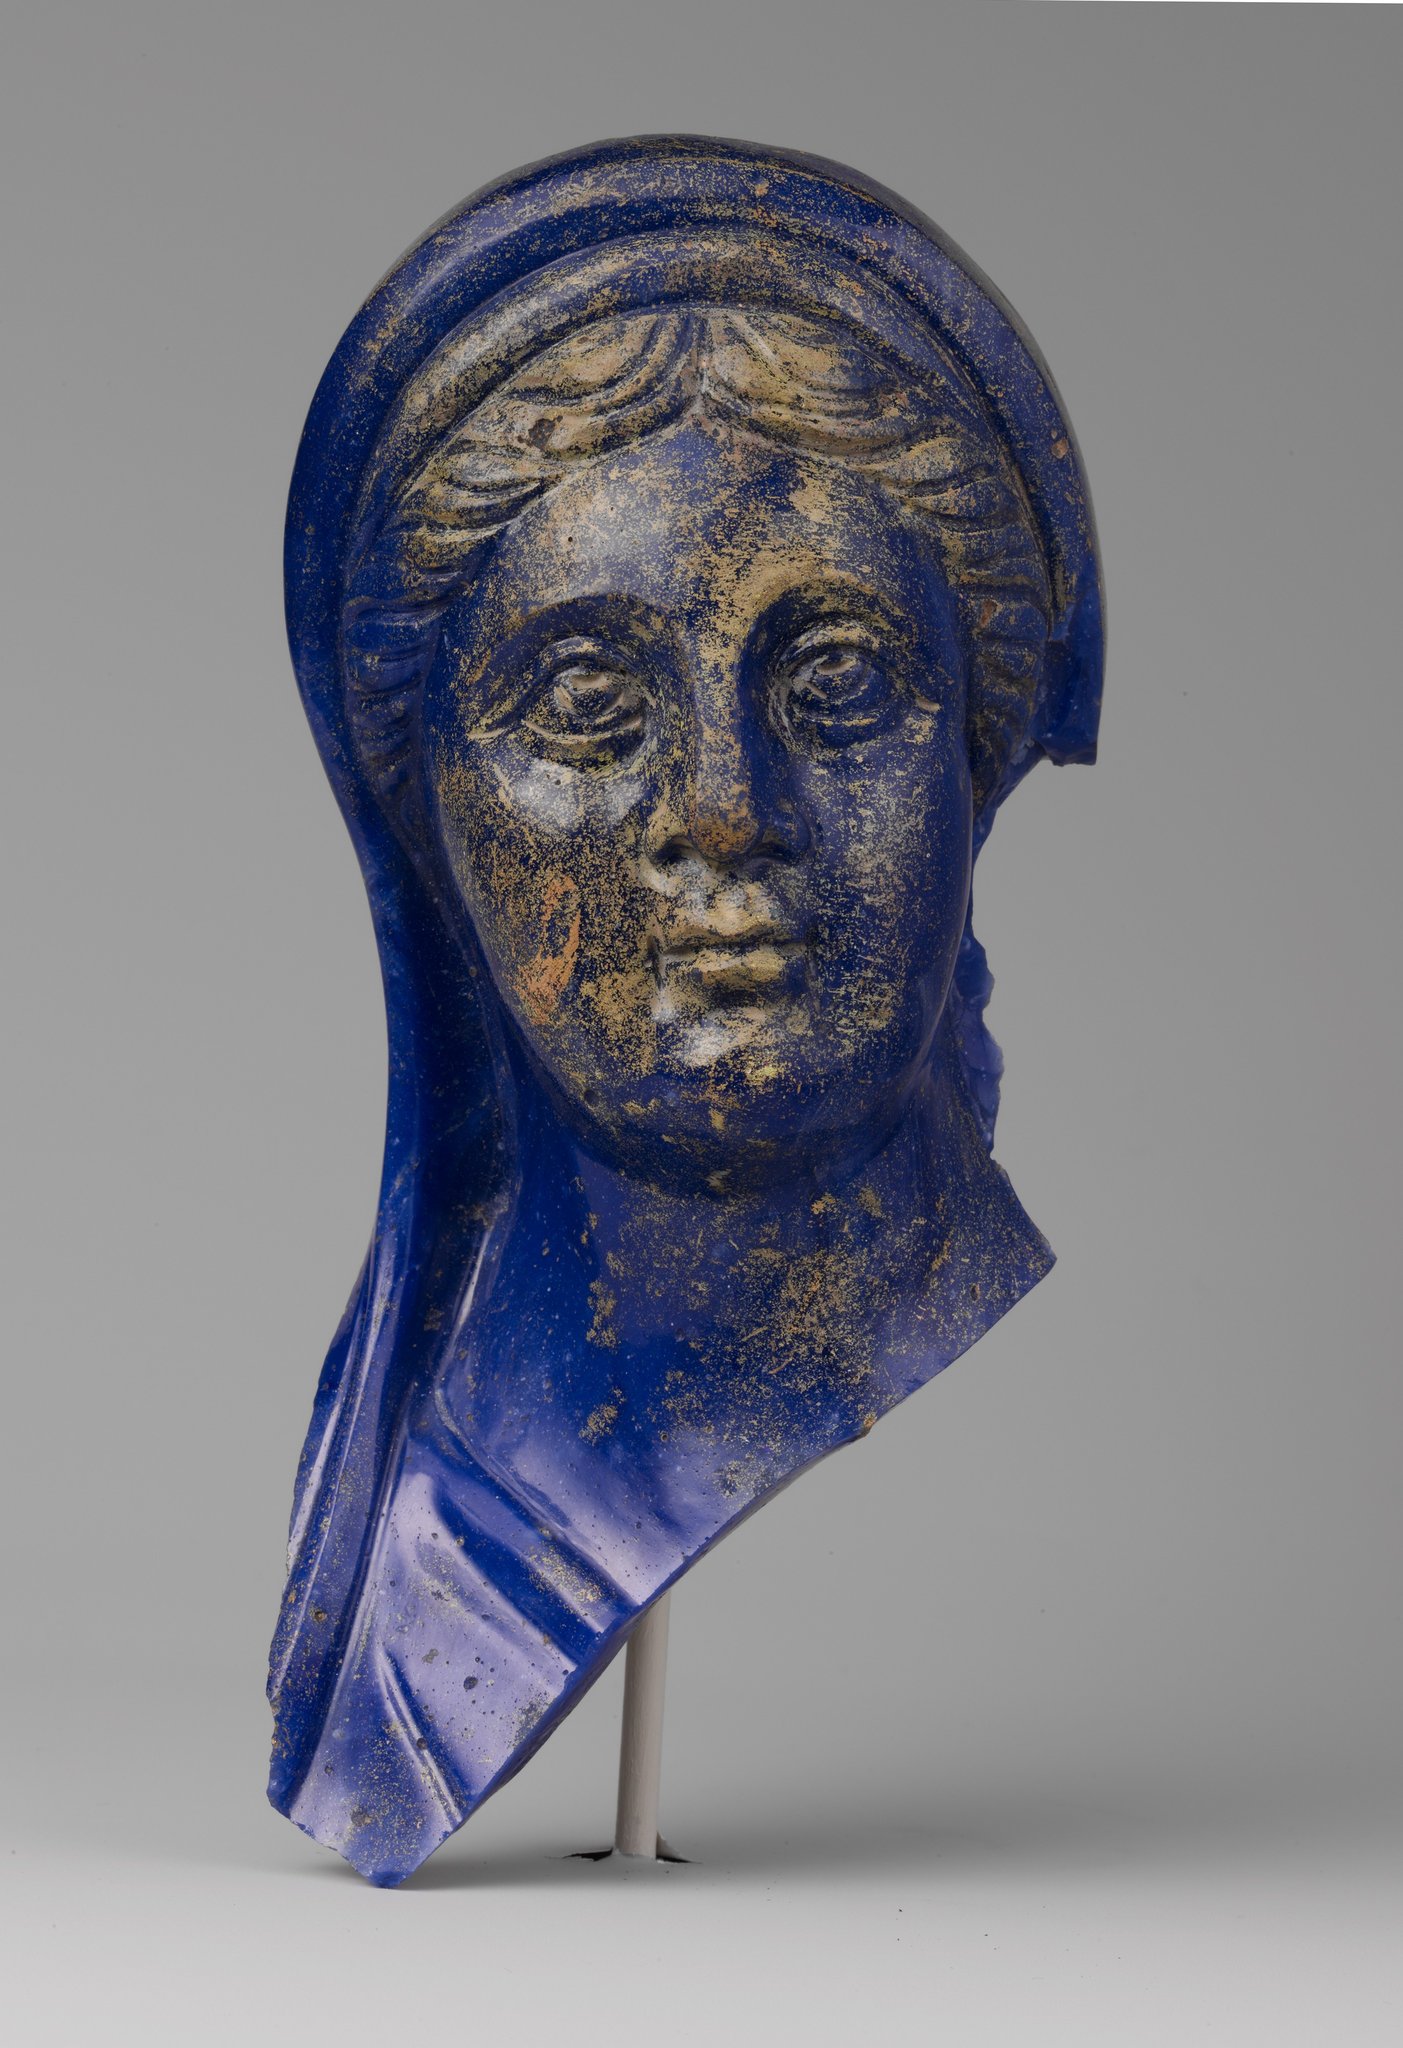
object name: head of a woman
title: Glass portrait head of a woman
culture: roman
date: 101-150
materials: glass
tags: heads,portraits,women